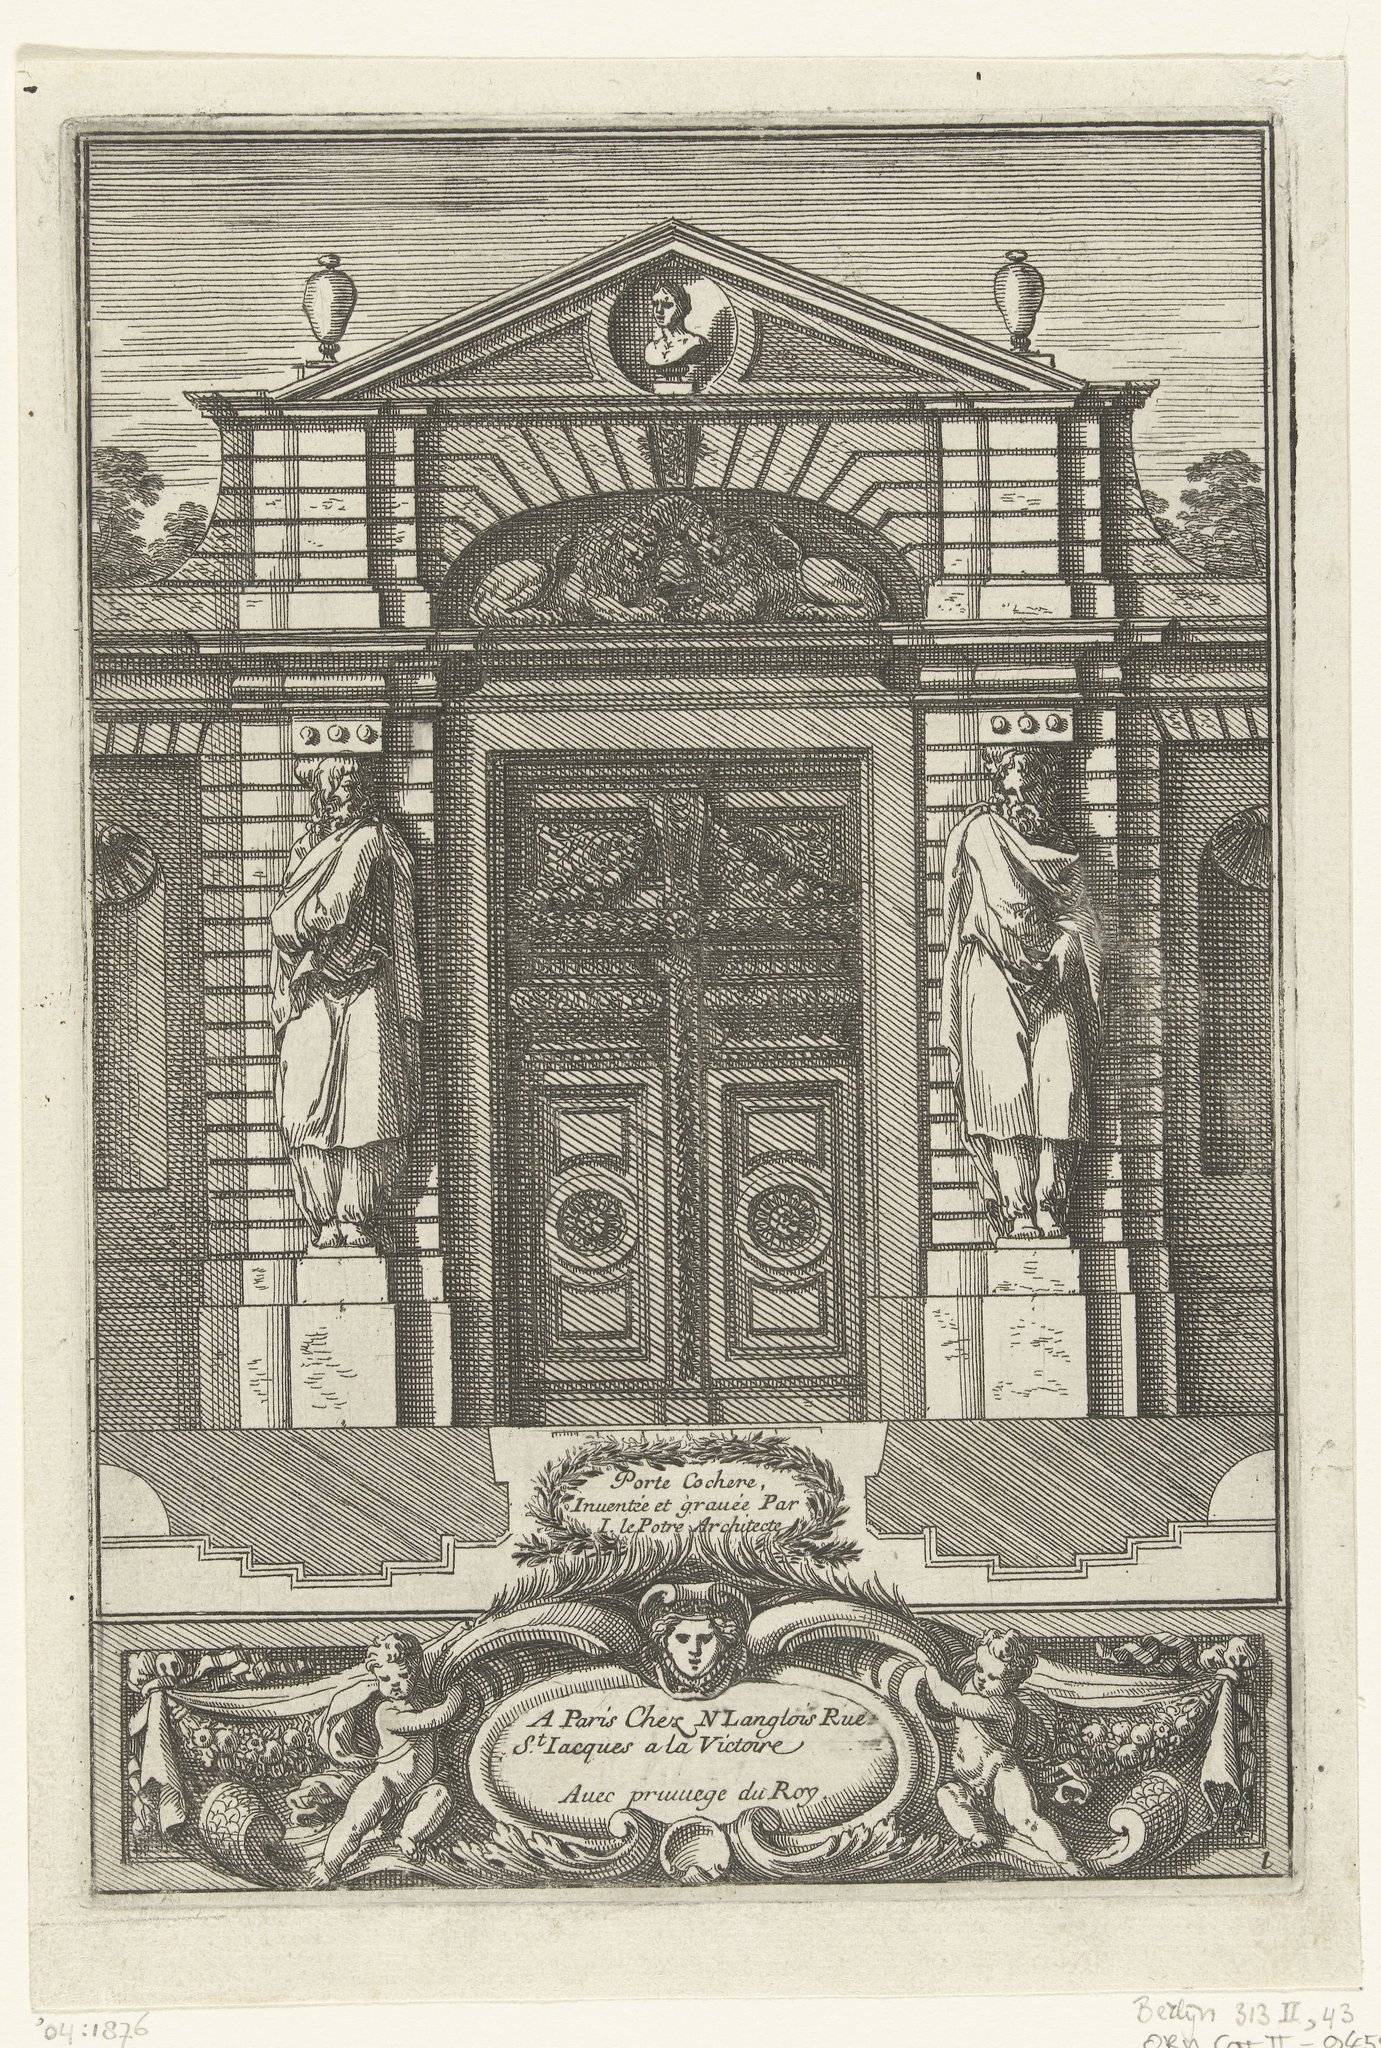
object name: ornament print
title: Porte Cochere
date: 1670-1680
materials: paper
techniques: etching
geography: france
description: Portiek met twee kariatiden in de vorm van gebaarde mannen. Opstand en plan.